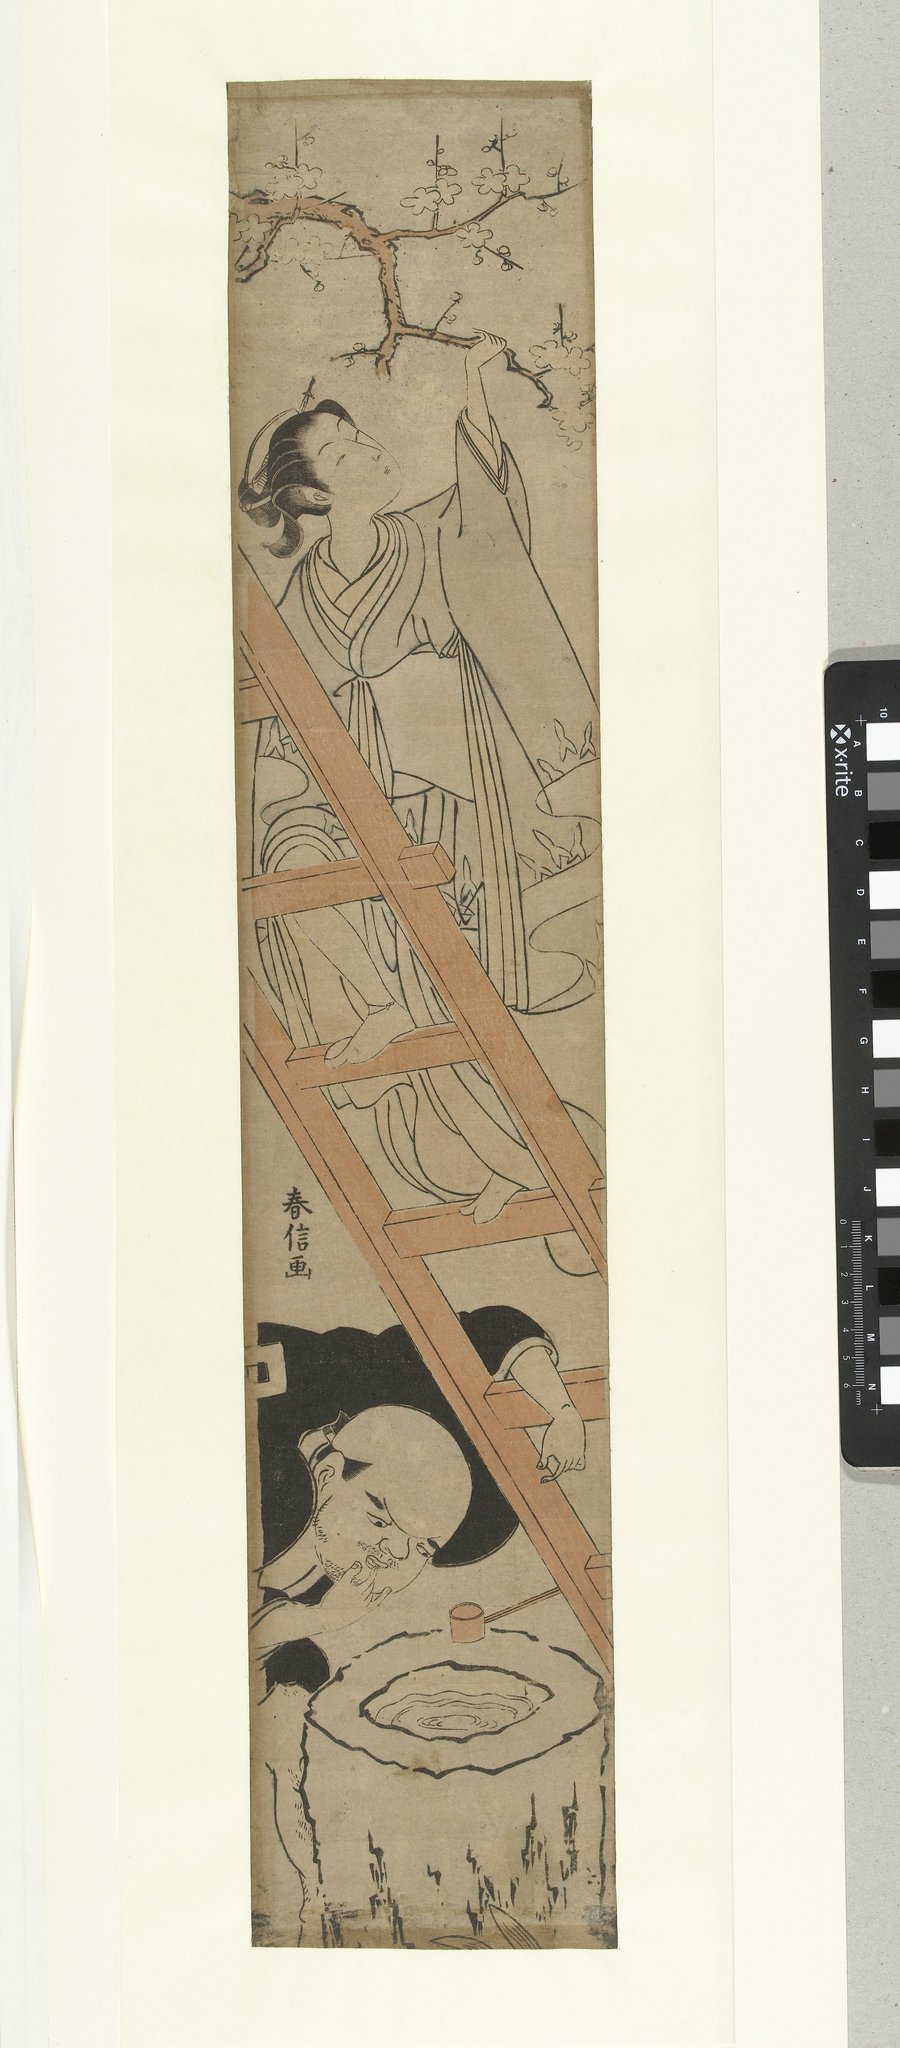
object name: print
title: Meisje op ladder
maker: suzuki harunobu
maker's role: print maker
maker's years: 1725-1770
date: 1765-1770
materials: paper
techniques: woodcut, nishiki e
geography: japan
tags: adolescent, young woman, maiden, plants; vegetation (+ flowers, blossom, blossoming), ladder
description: Meisje op ladder een bloesemtak vasthoudend, terwijl een bediende onder haar rok probeert te kijken via de weerspiegeling in het water.